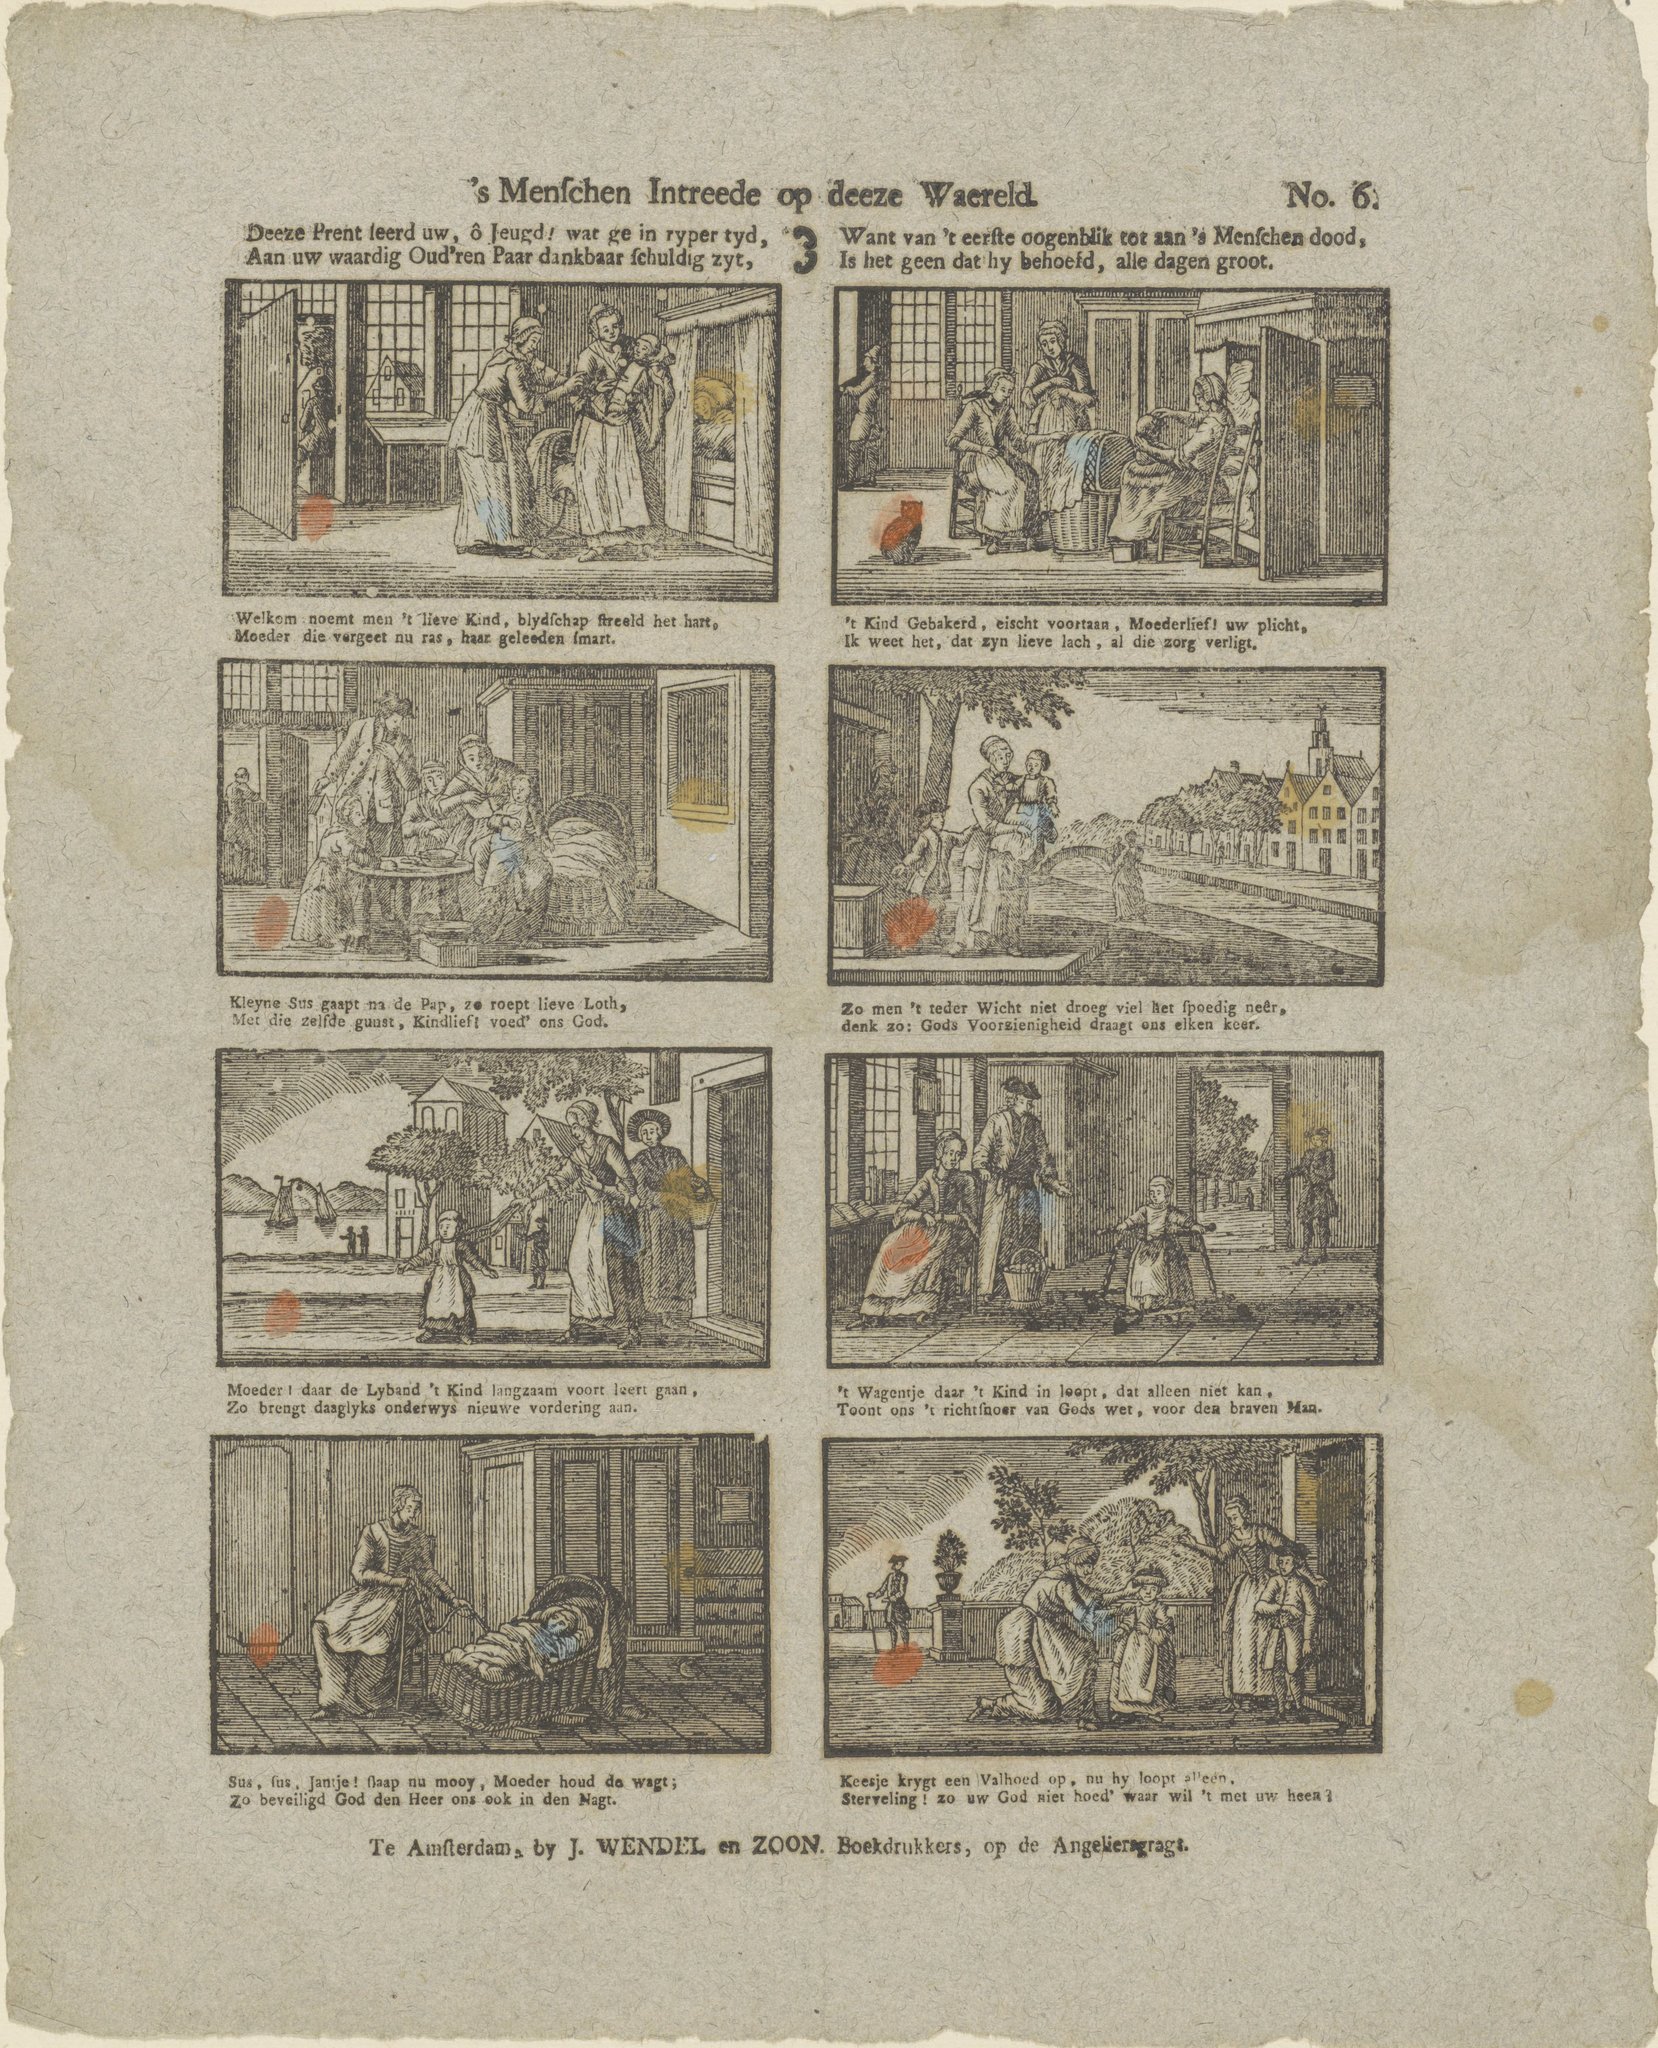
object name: print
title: 's Menschen Intreede op deeze waereld. / Deeze prent leerd uw, ô jeugd! wat ge in ryper tyd, / aan uw waardig Oud'ren paar dankbaar schuldig zyt, / Want van 't eerste oogenblik tot aan 's menschen dood, / Is het geen dat hy behoefd, alle dagen groot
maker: Anonymous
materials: paper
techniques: colour, letterpress printing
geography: amsterdam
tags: child, learning to walk, the first steps, human life divided into stages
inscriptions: collector's mark: Lugt 2760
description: Blad met 8 voorstellingen over het kinderleven. Onder elke afbeelding een tweeregelig vers. Genummerd rechtsboven: No. 6.